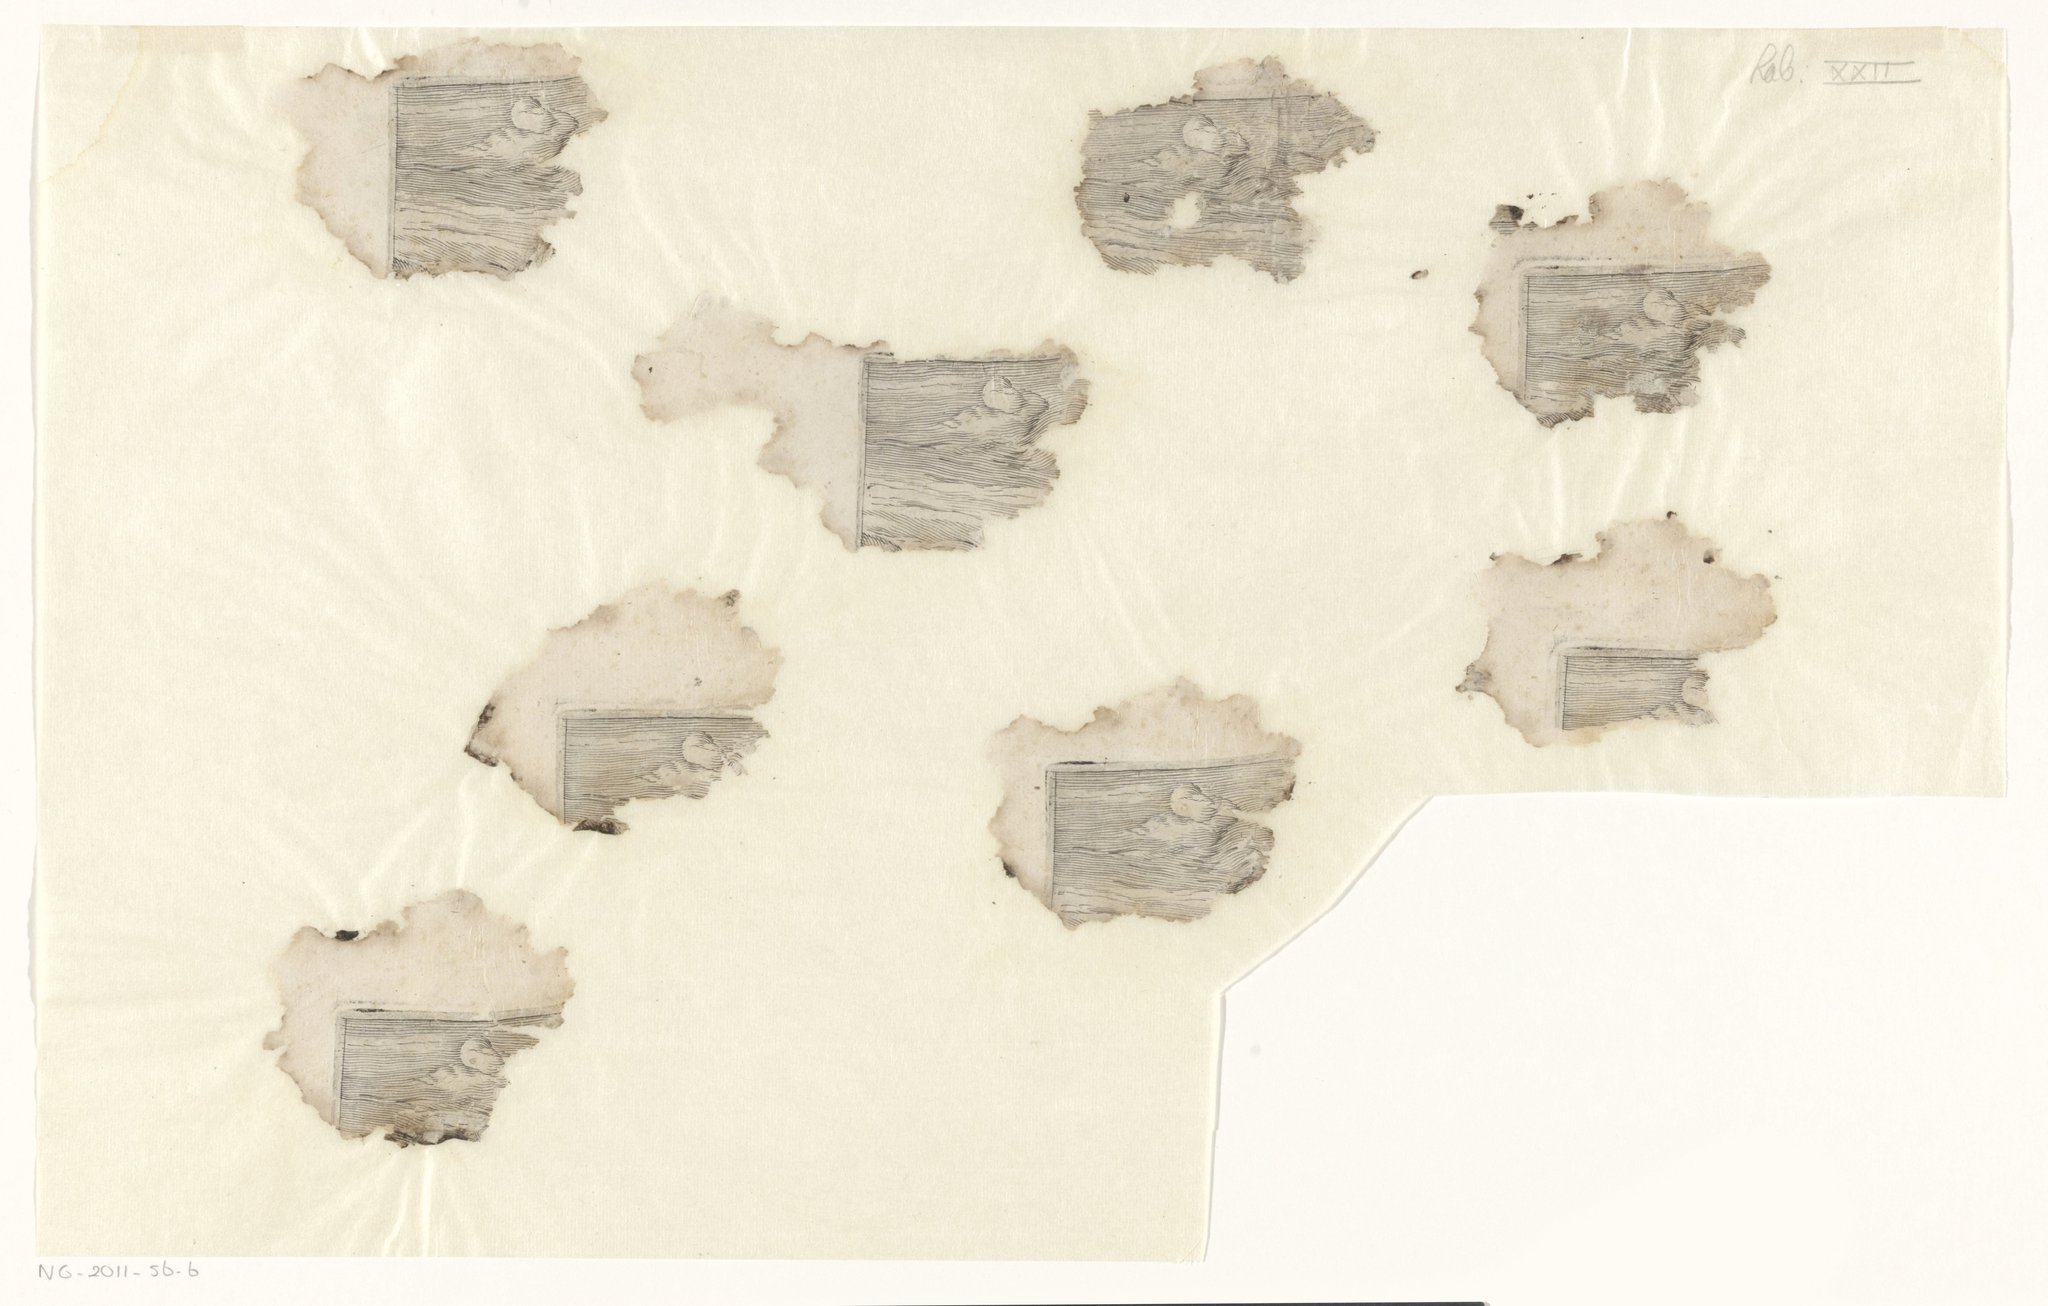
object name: print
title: Losse fragmenten van prenten van de grote Hercules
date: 1589-1596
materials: paper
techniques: engraving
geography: northern netherlands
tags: (story of) hercules (heracles)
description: De prenten in de Nova Zembla collectie zijn tijdens een expeditie van Willem Barendsz en Jacob van Heemskerk in 1596-1597 noodgedwongen in het winterkamp, het ‘Behouden Huis’, op het eiland achtergelaten. De prenten waren in één of meerdere stapels als handelswaar meegenomen vanuit Amsterdam. Bijna drie eeuwen later, in 1871, keerde de Noor Elling Carlsen terug naar Nova Zembla en vond daar de restanten van het ‘Behouden Huis, inclusief een groot deel van de inventaris. Een deel van de prenten, in de vorm van aaneengekoekte kluiten, werd toen ook teruggevonden. De papierkluiten waren soms op meerdere plekken gebroken. Tussen 1975-1979 zijn de prenten van elkaar gescheiden. Dit leverde in totaal ca. 1000 fragmenten van ca. 400 afdrukken van ca. 150 verschillende prenten op. Voor zover mogelijk zijn de fragmenten samengevoegd en zijn de prenten gereconstrueerd.